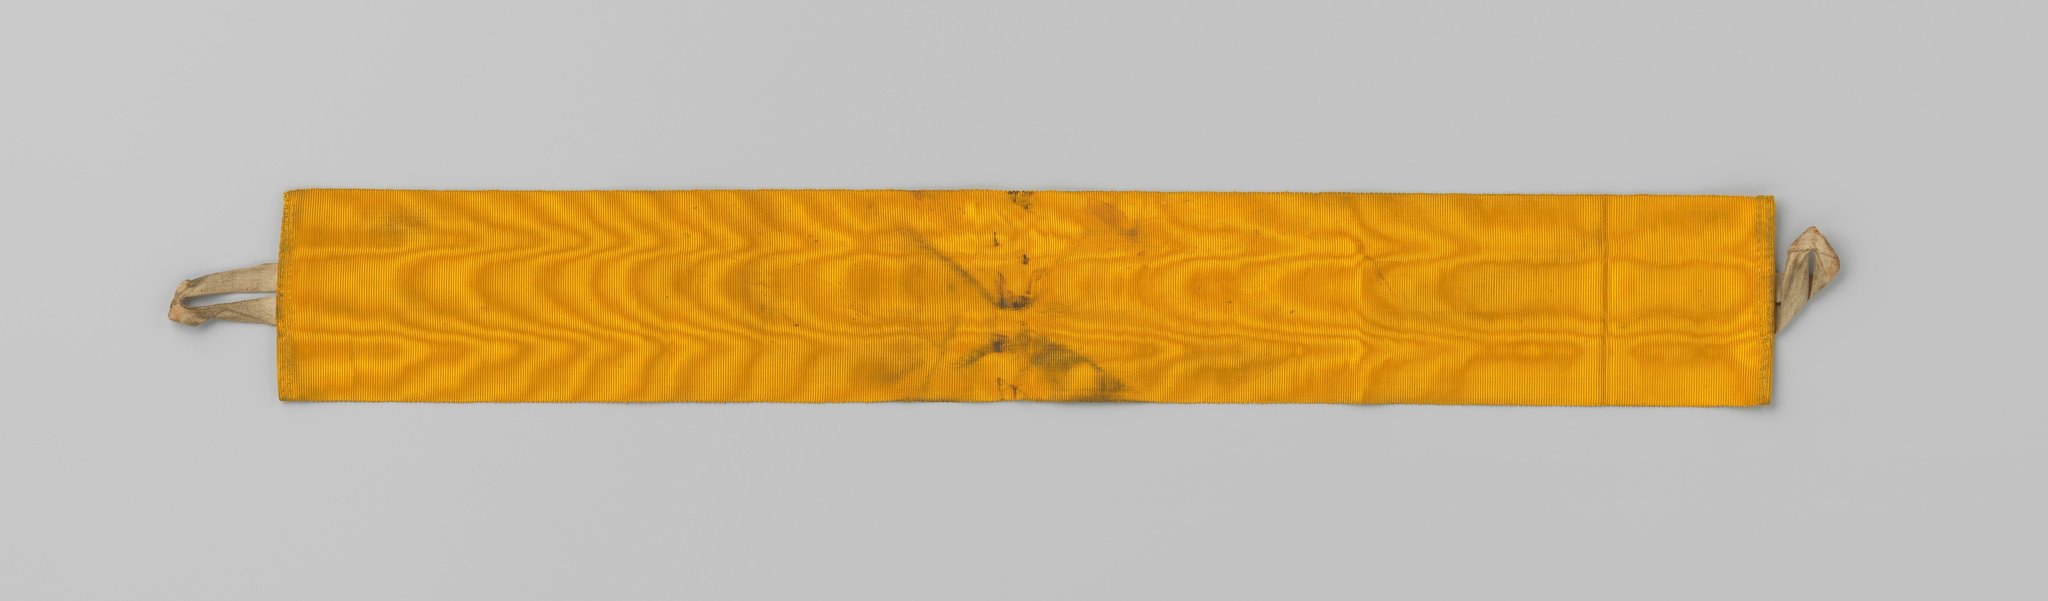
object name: band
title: Band van oranje moiré zijde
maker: Anonymous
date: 1850-1950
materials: silk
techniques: moire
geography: europe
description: Aan weerszijden van de band een lus met een knoopsgat van wit textiel.